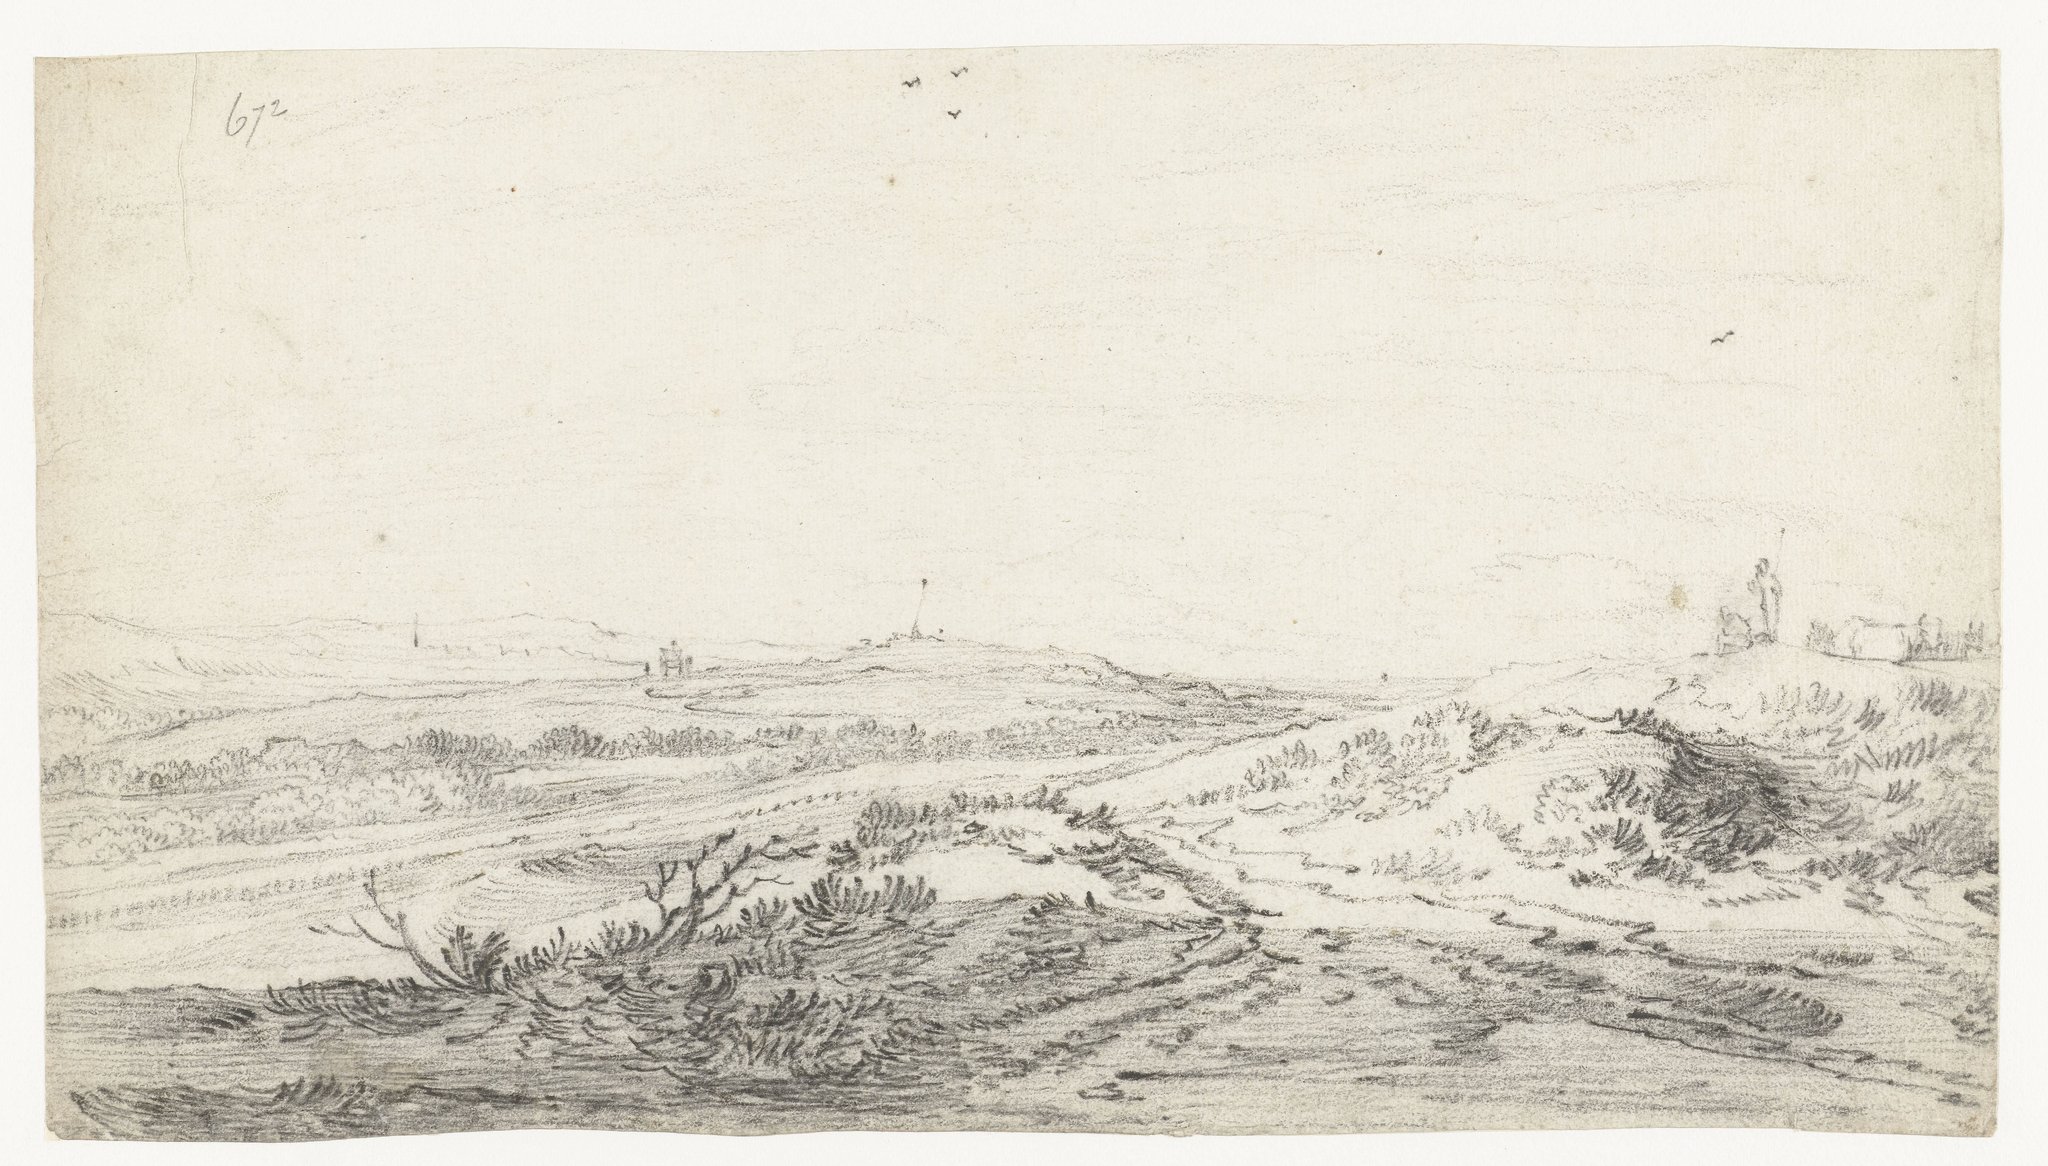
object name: drawing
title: Duinlandschap met in de verte een zee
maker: pieter de molijn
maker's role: draughtsman, painter, print maker, publisher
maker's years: 1595-1661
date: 1650-1660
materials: chalk, paper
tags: dunes (sea not visible); in the dunes